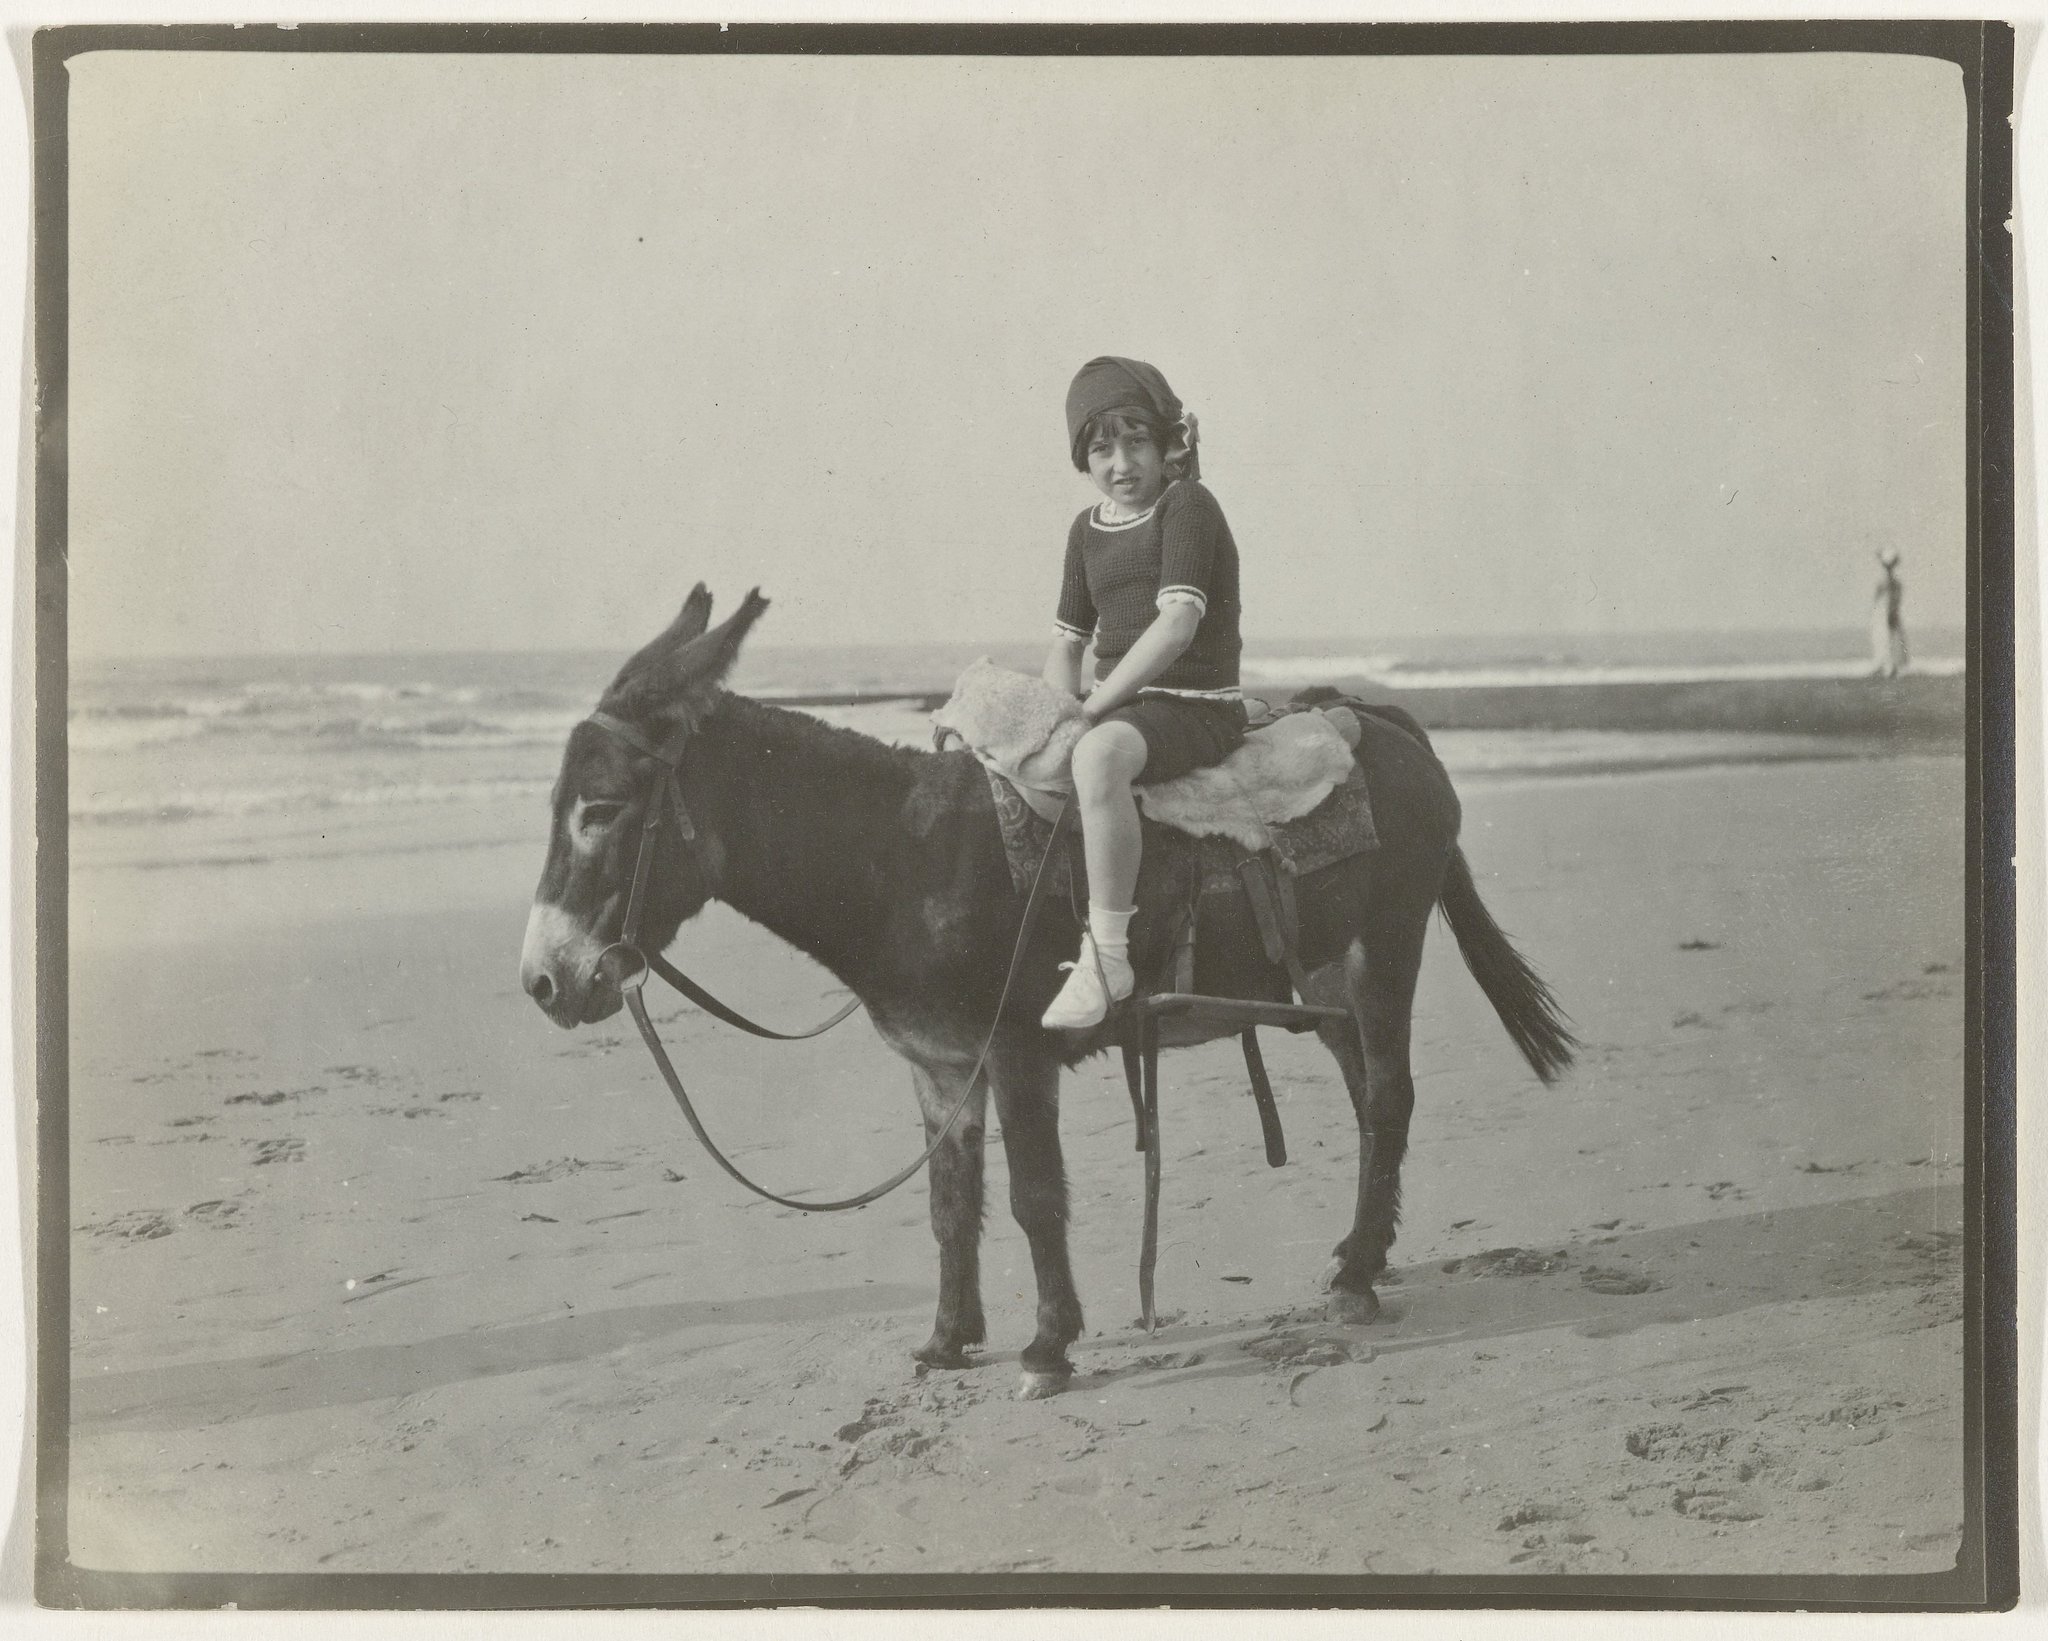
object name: photograph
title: Meisje op ezel aan het strand (Noordzeekust), Nederland of Duitsland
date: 1900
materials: paper, photographic support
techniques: gelatin silver print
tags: donkey-riding (on the beach), netherlands, germany